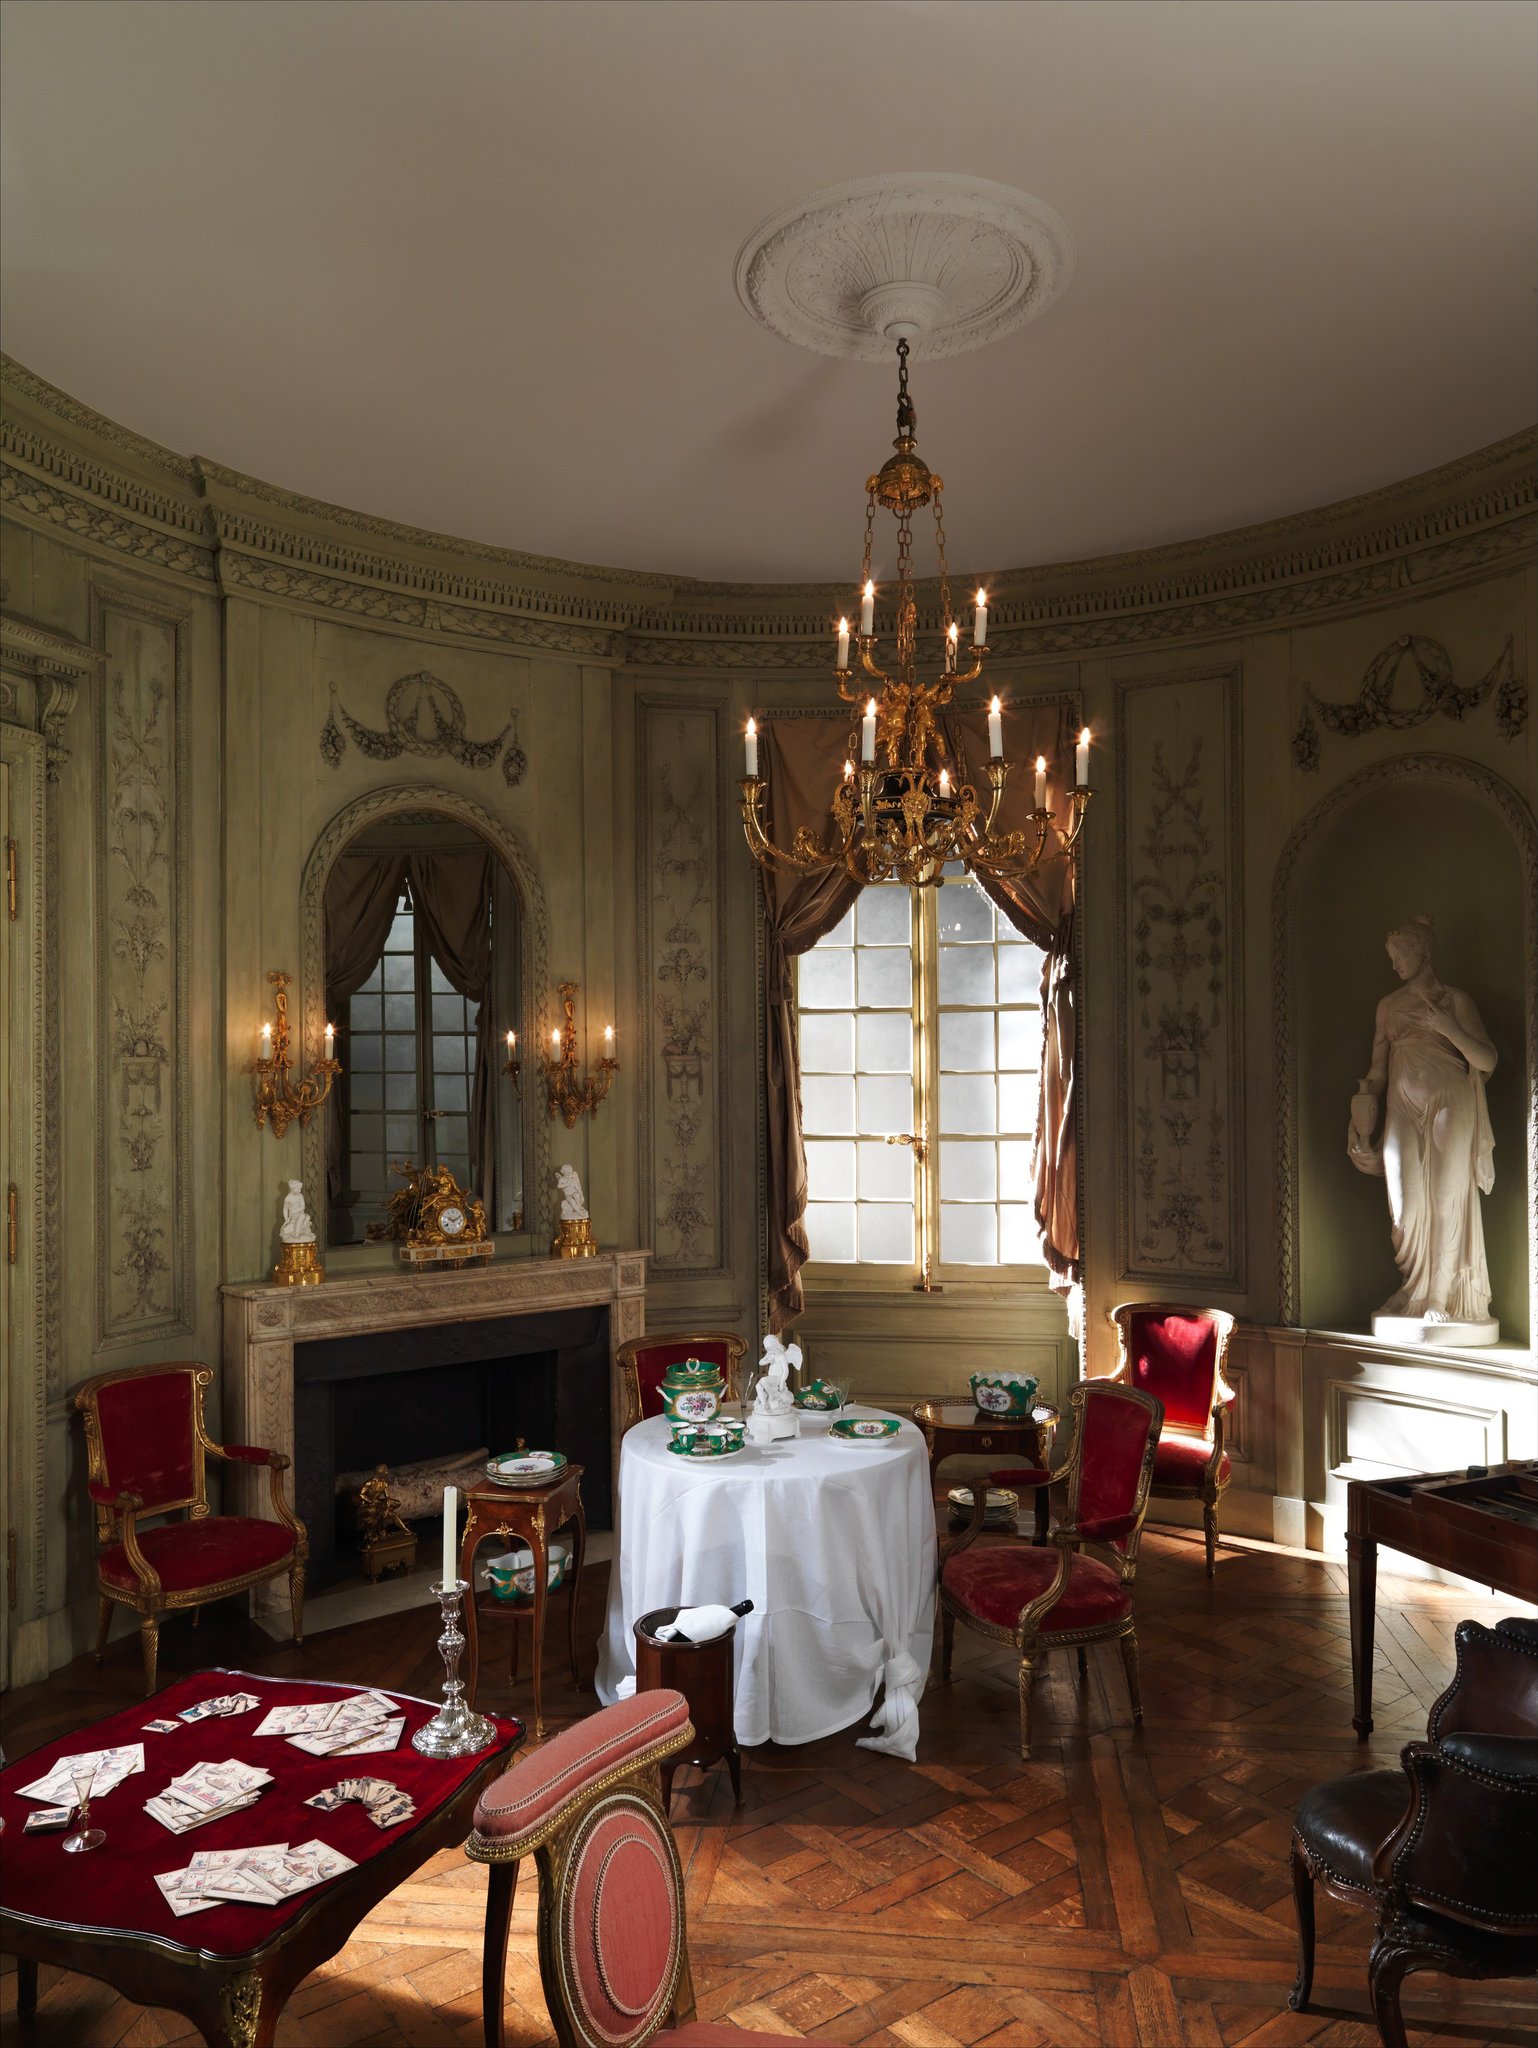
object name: period room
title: Room from a hotel in the Cours d'Albret, Bordeaux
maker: barthélemy cabirol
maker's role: maker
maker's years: 1732-1786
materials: wood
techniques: carving, painting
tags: interiors